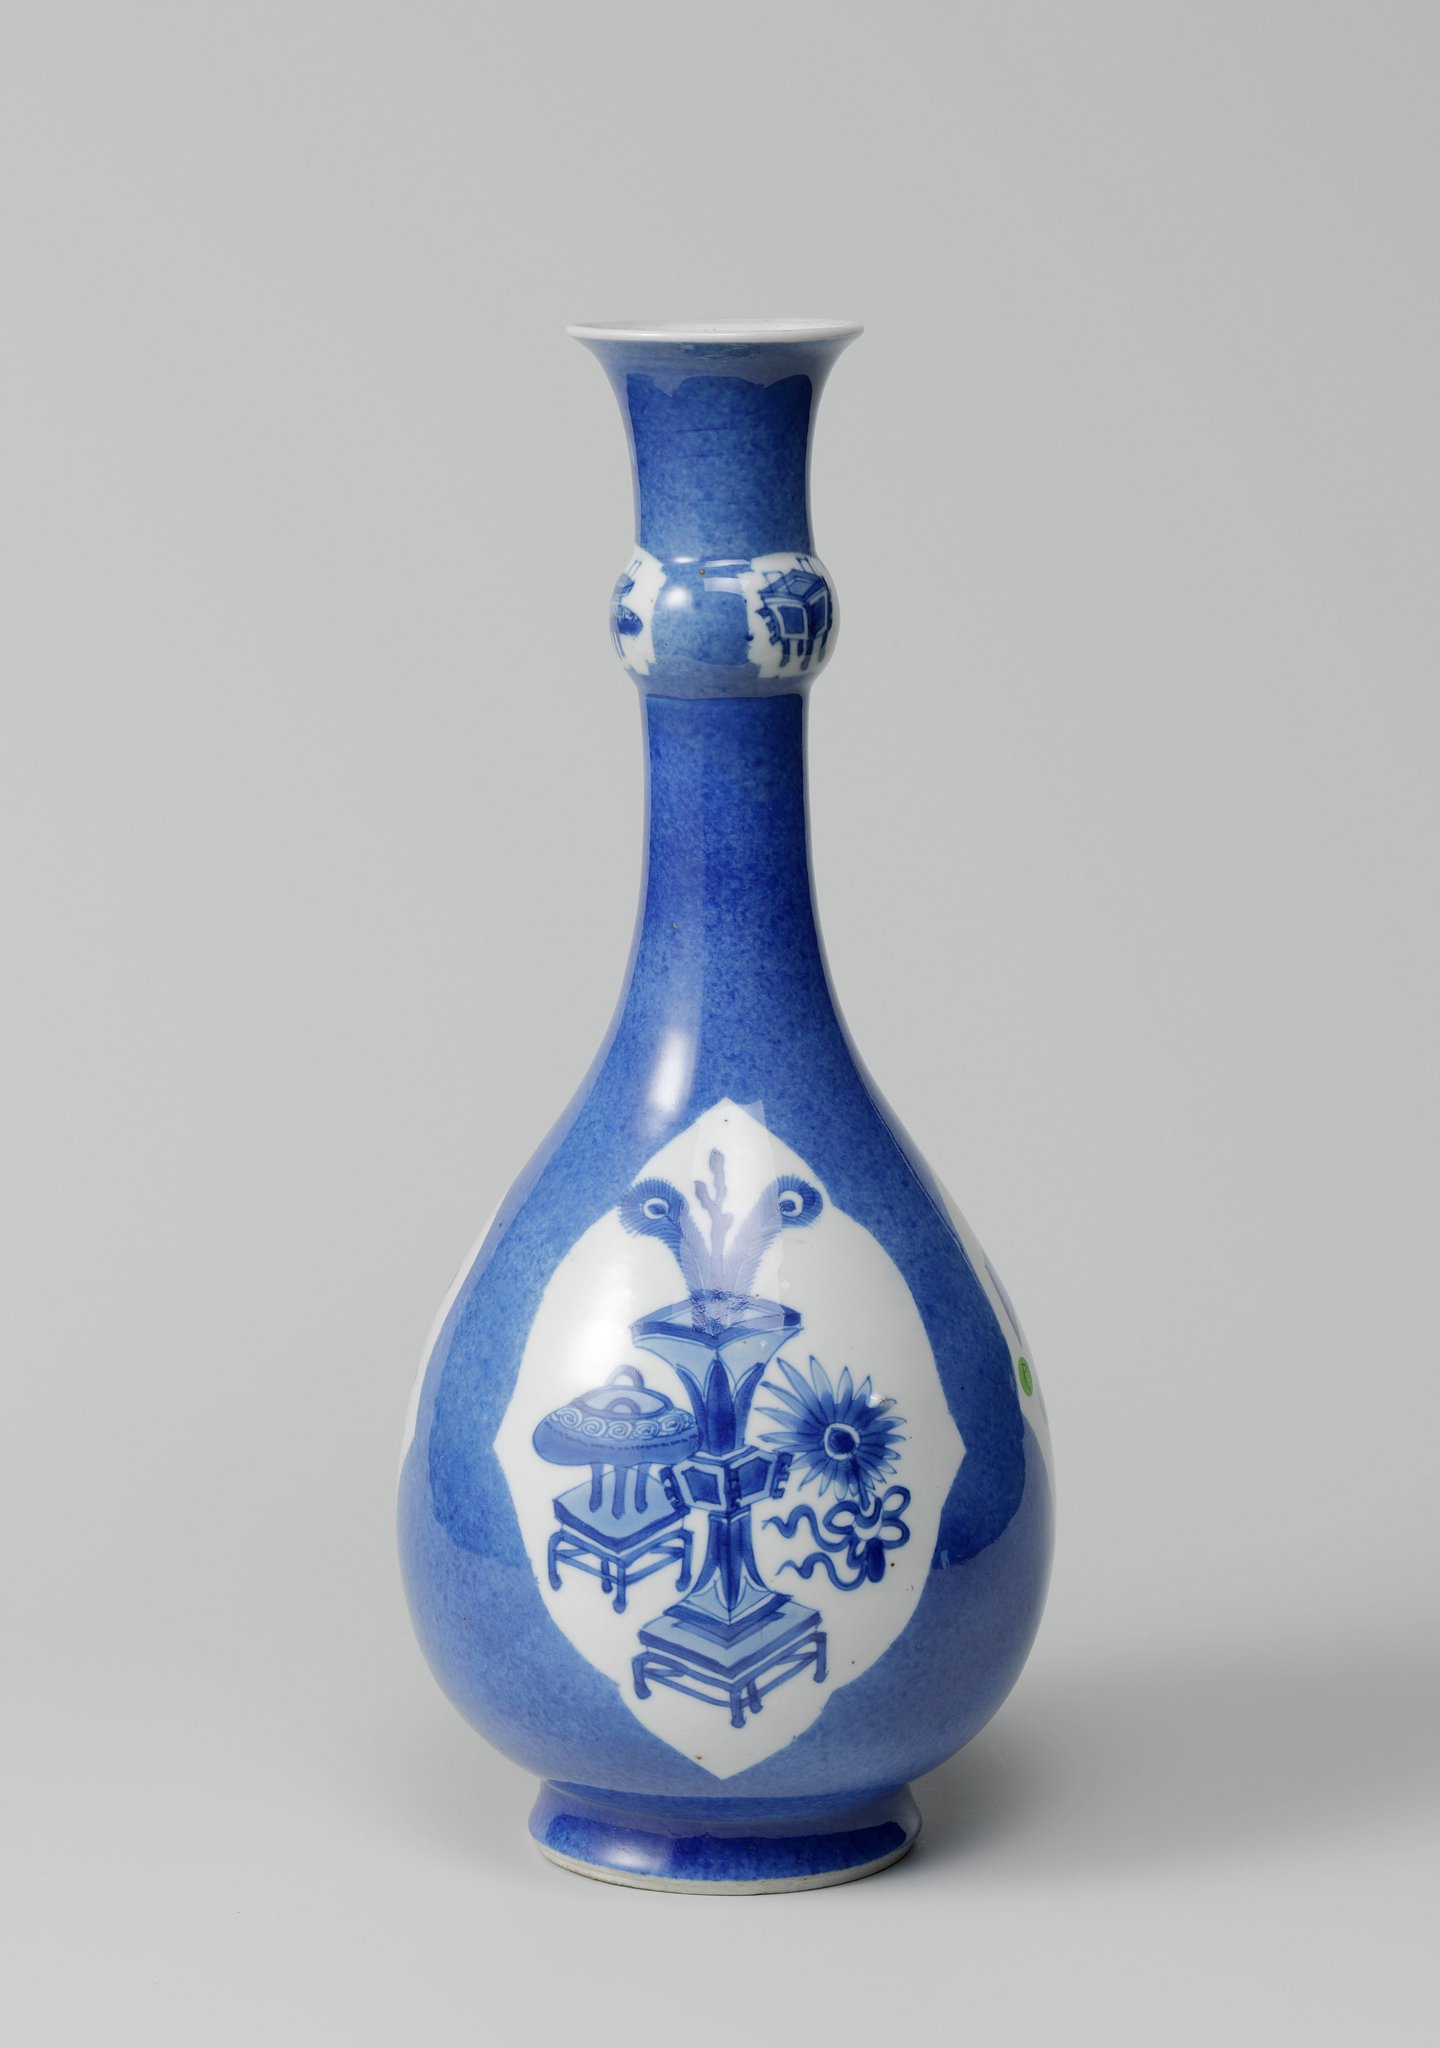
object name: bottle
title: Bottle vase with powder blue, antiquities and precious objects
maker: Anonymous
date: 1700-1724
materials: cobalt, glaze, paint, porcelain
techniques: firing, turning, vitrification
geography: china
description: Peervormige fles met een lange, uitlopende hals met onder de mond een smalle verdikking. Bedekt met bleu poudré waarin op de buik drie grote geschulpte velden en op de verdikking op de hals drie kleine velden, alle gevuld met kostbaarheden.